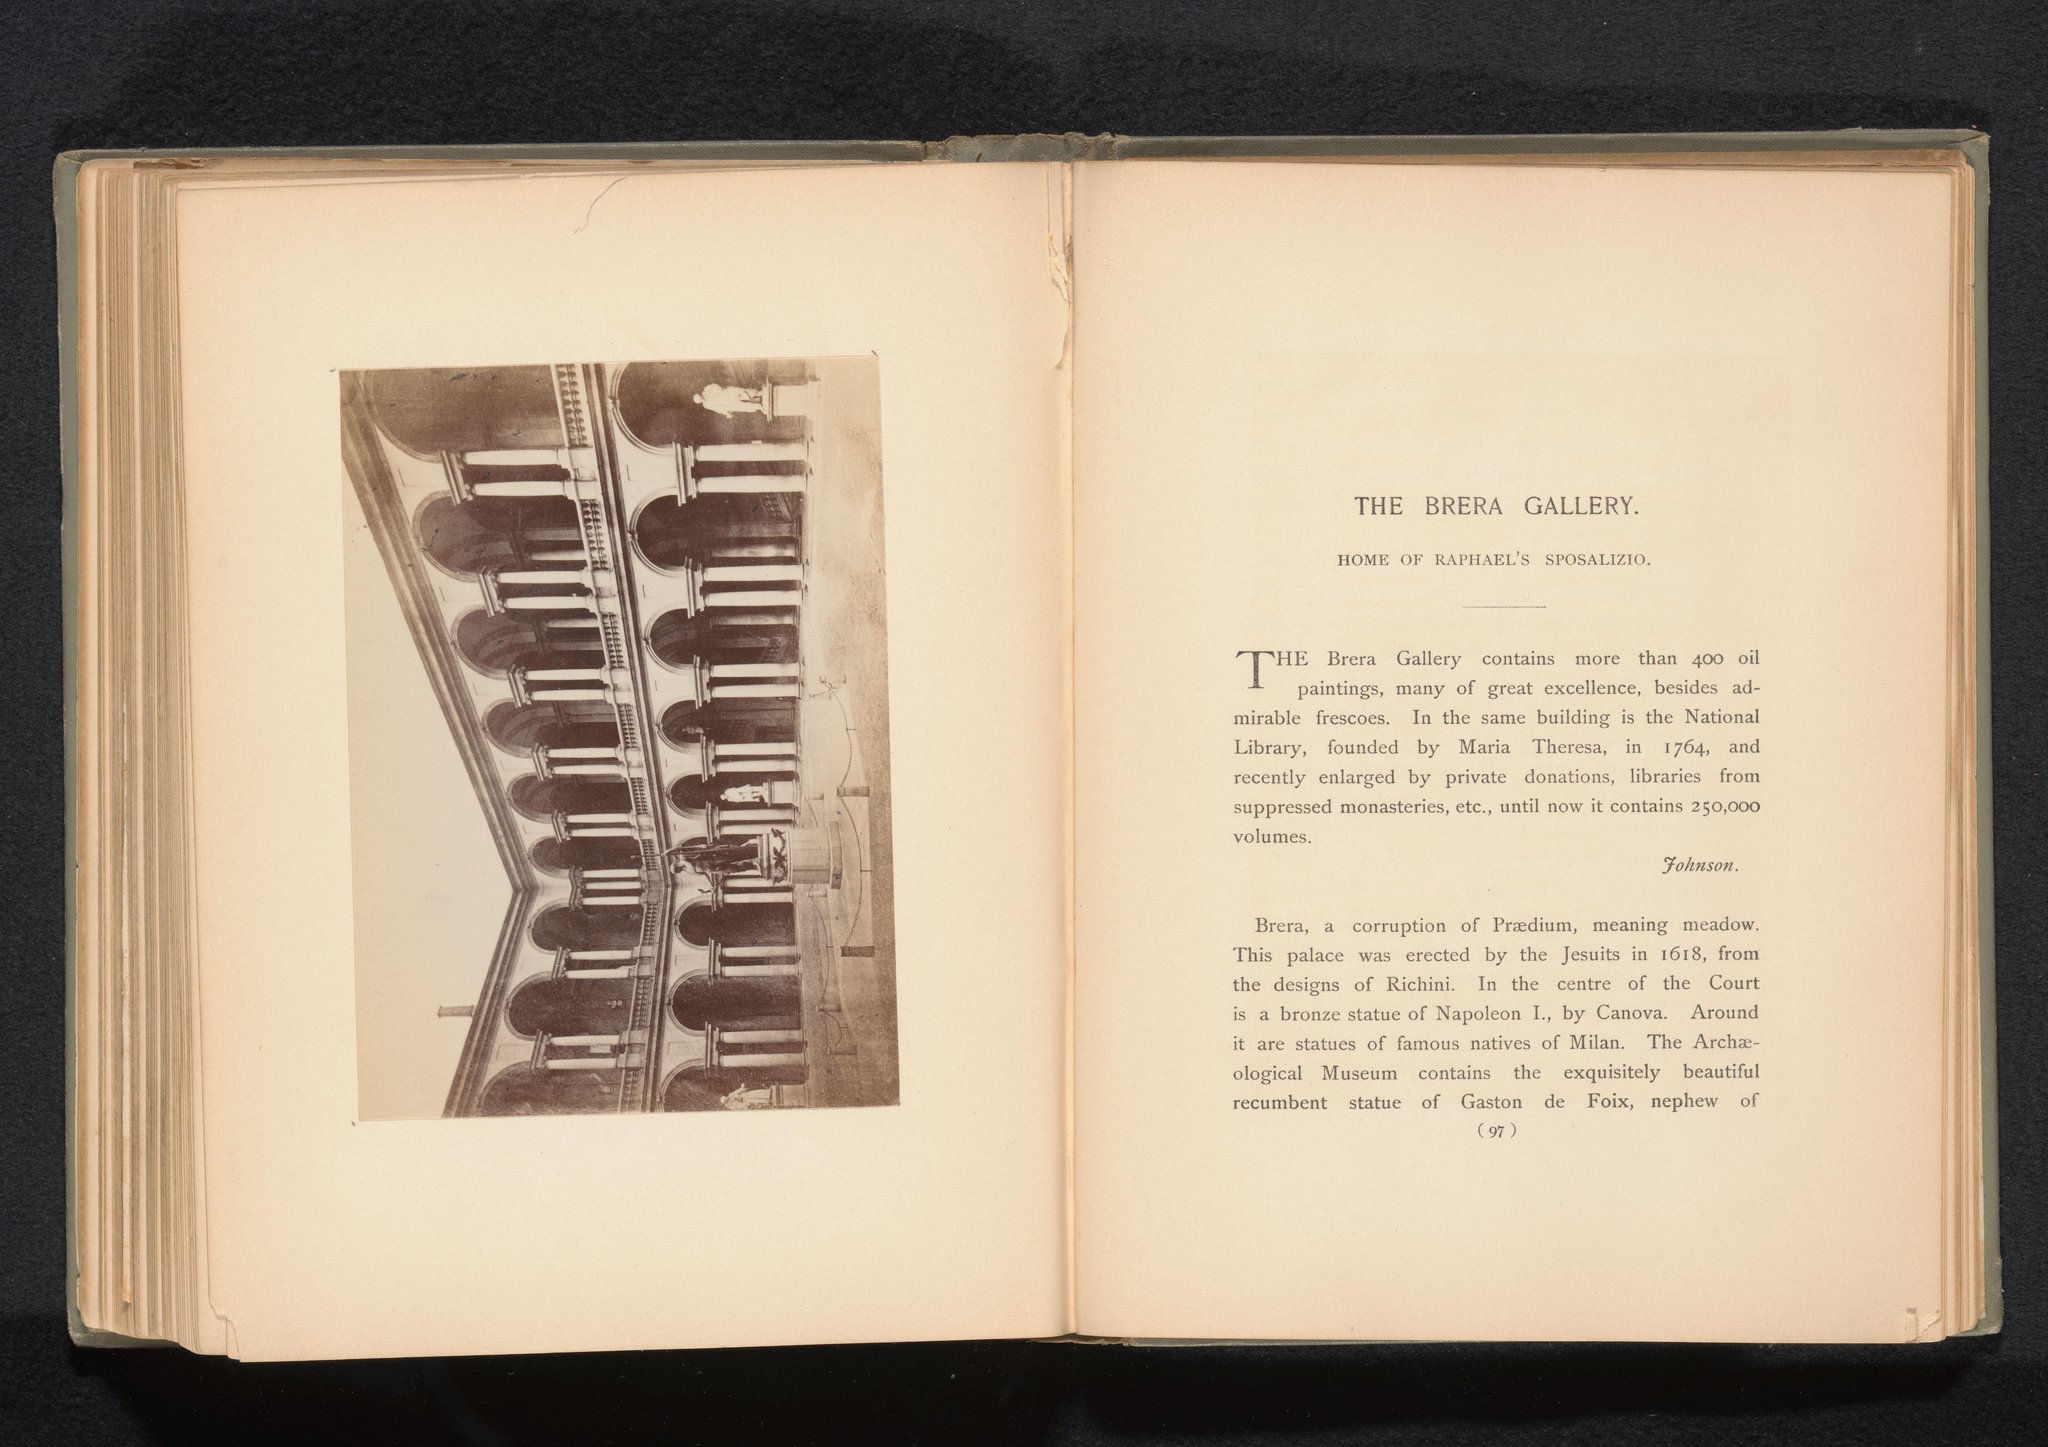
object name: photograph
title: Binnenplaats van de Pinacoteca di Brera te Milaan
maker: Anonymous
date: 1882-1887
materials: photographic support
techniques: albumen print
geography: milan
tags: façade of inner court, permanent exhibition, museum, façade (of house or building)